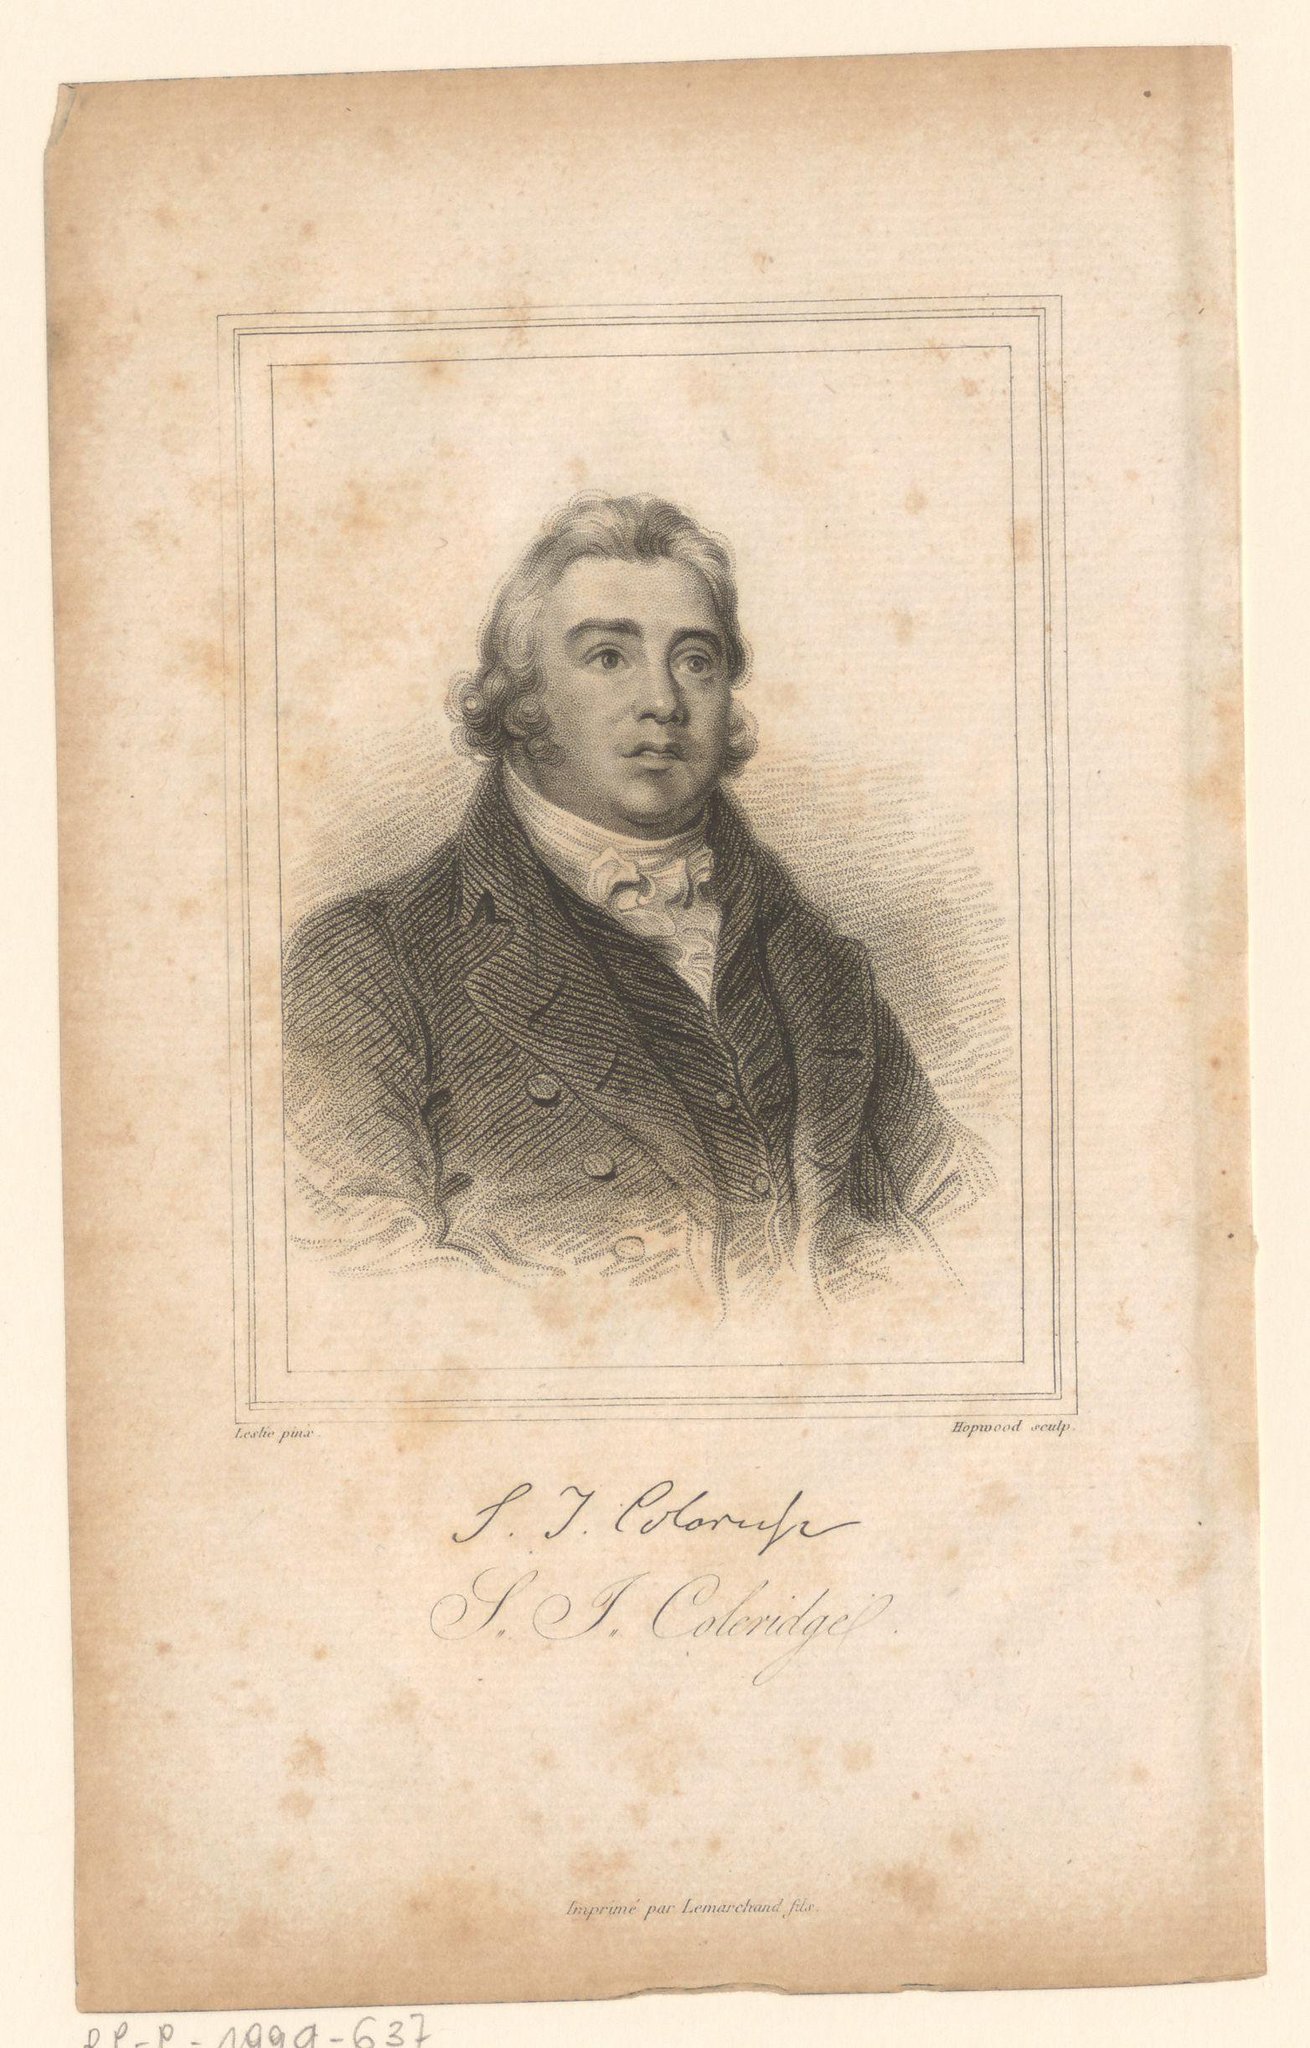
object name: print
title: S. T. Coleridge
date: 1828-1850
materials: paper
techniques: etching, roulette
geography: paris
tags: london, historical persons, portrait of a writer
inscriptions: collector's mark: Lugt 2228, collector's mark: Lugt 2760